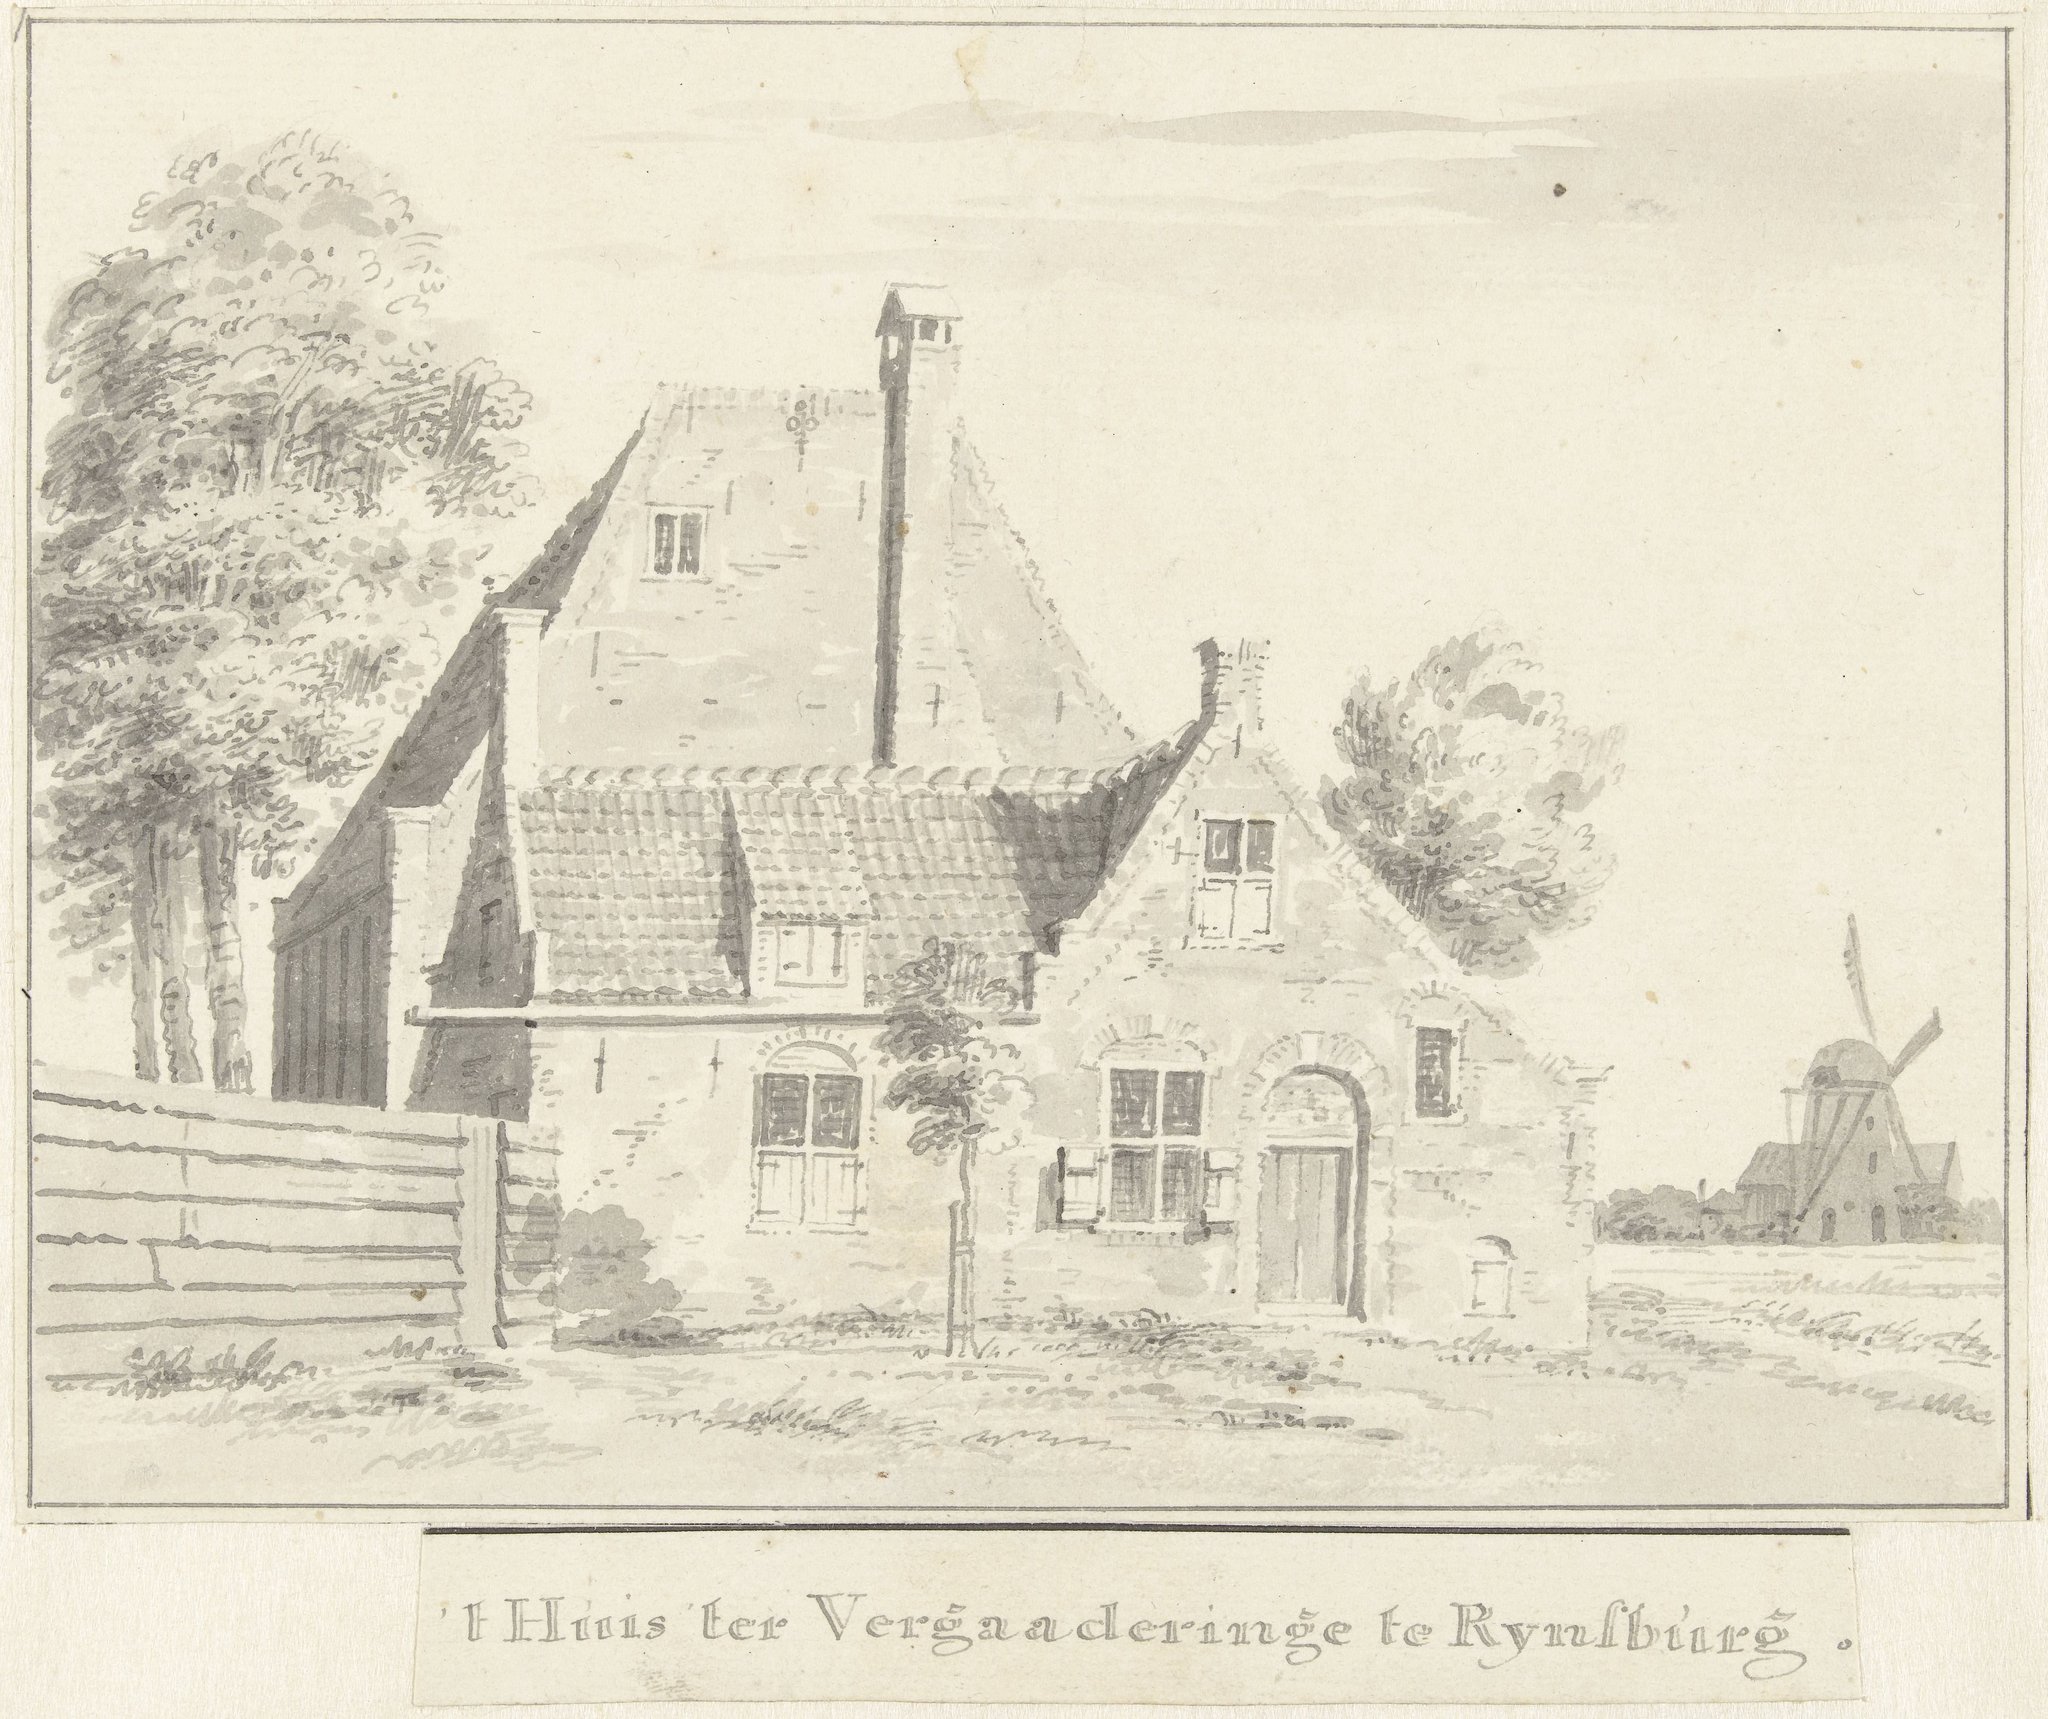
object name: drawing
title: Het vergaderhuis van de Collegianten te Rijnsburg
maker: cornelis pronk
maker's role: draughtsman, painter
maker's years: 1691-1759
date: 1701-1759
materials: ink, paper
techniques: brush, pen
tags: protestant churches and denominations (with name), the place of worship and its equipment ~ christian churches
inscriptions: inscription: ‘'t Huis ter Vergaaderinge te Rynsburg.’